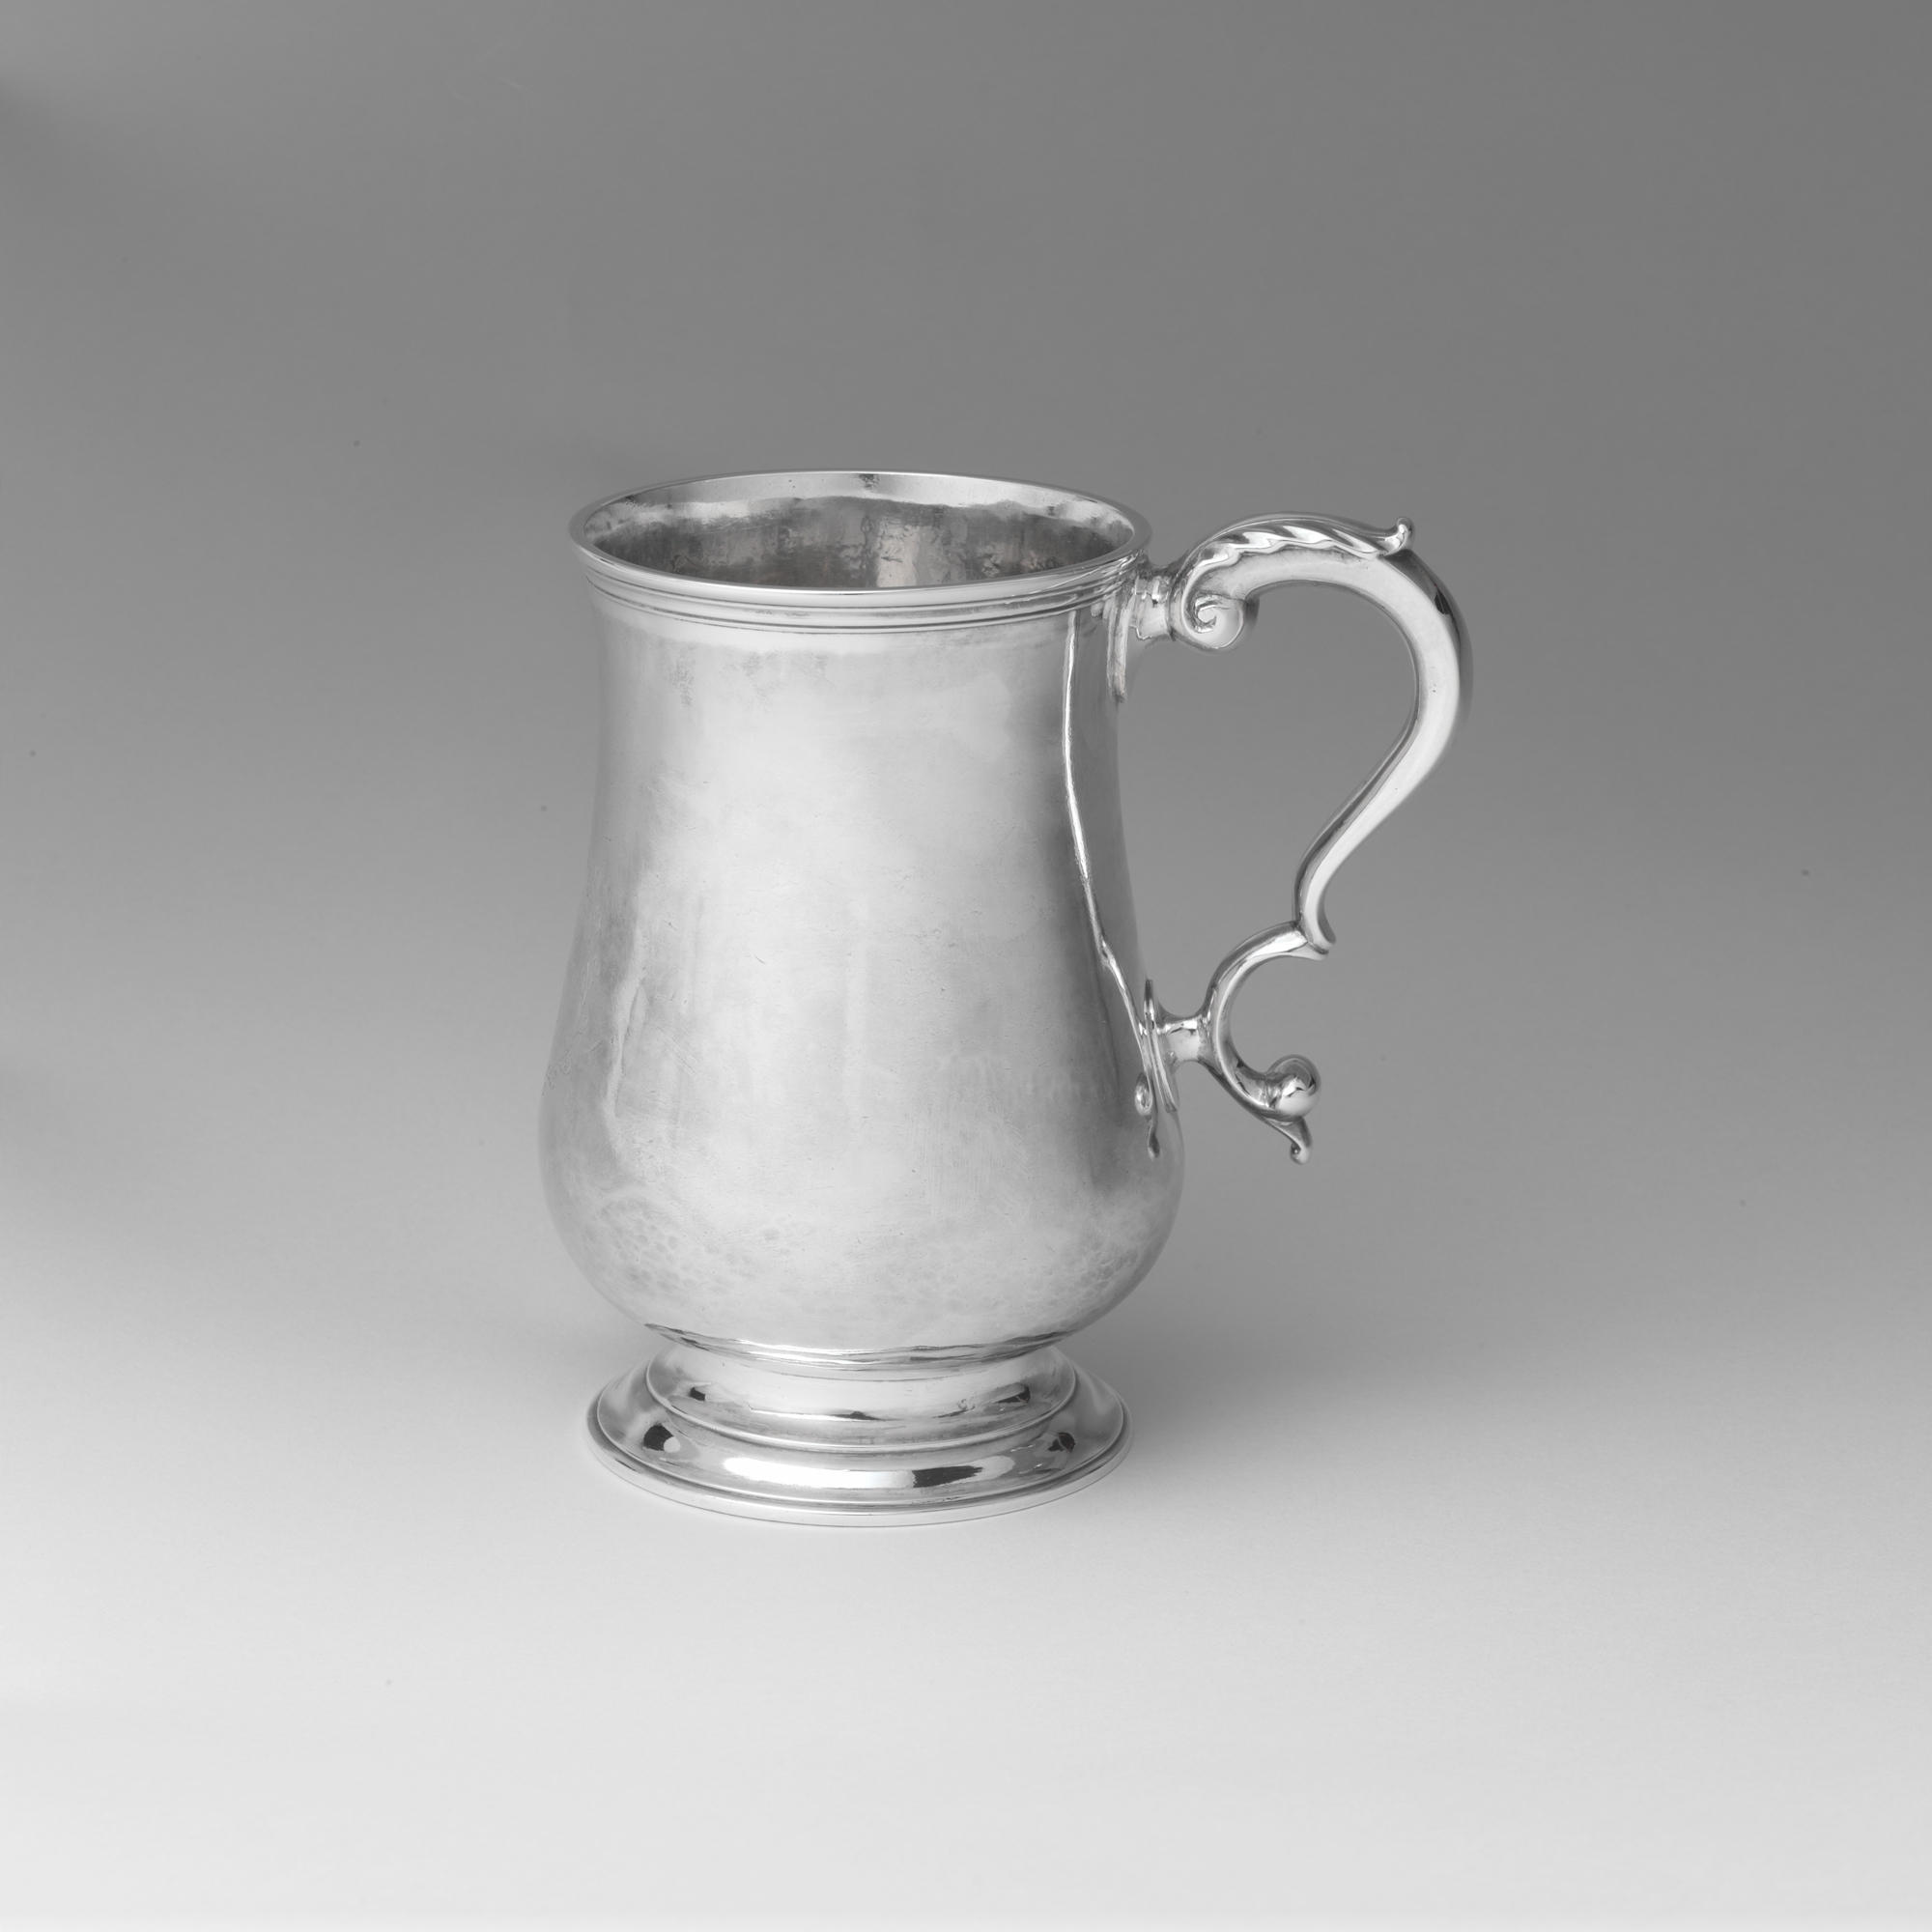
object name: cann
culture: american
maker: stephen emery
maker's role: maker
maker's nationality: american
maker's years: 1749-1801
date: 1785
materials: silver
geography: united states